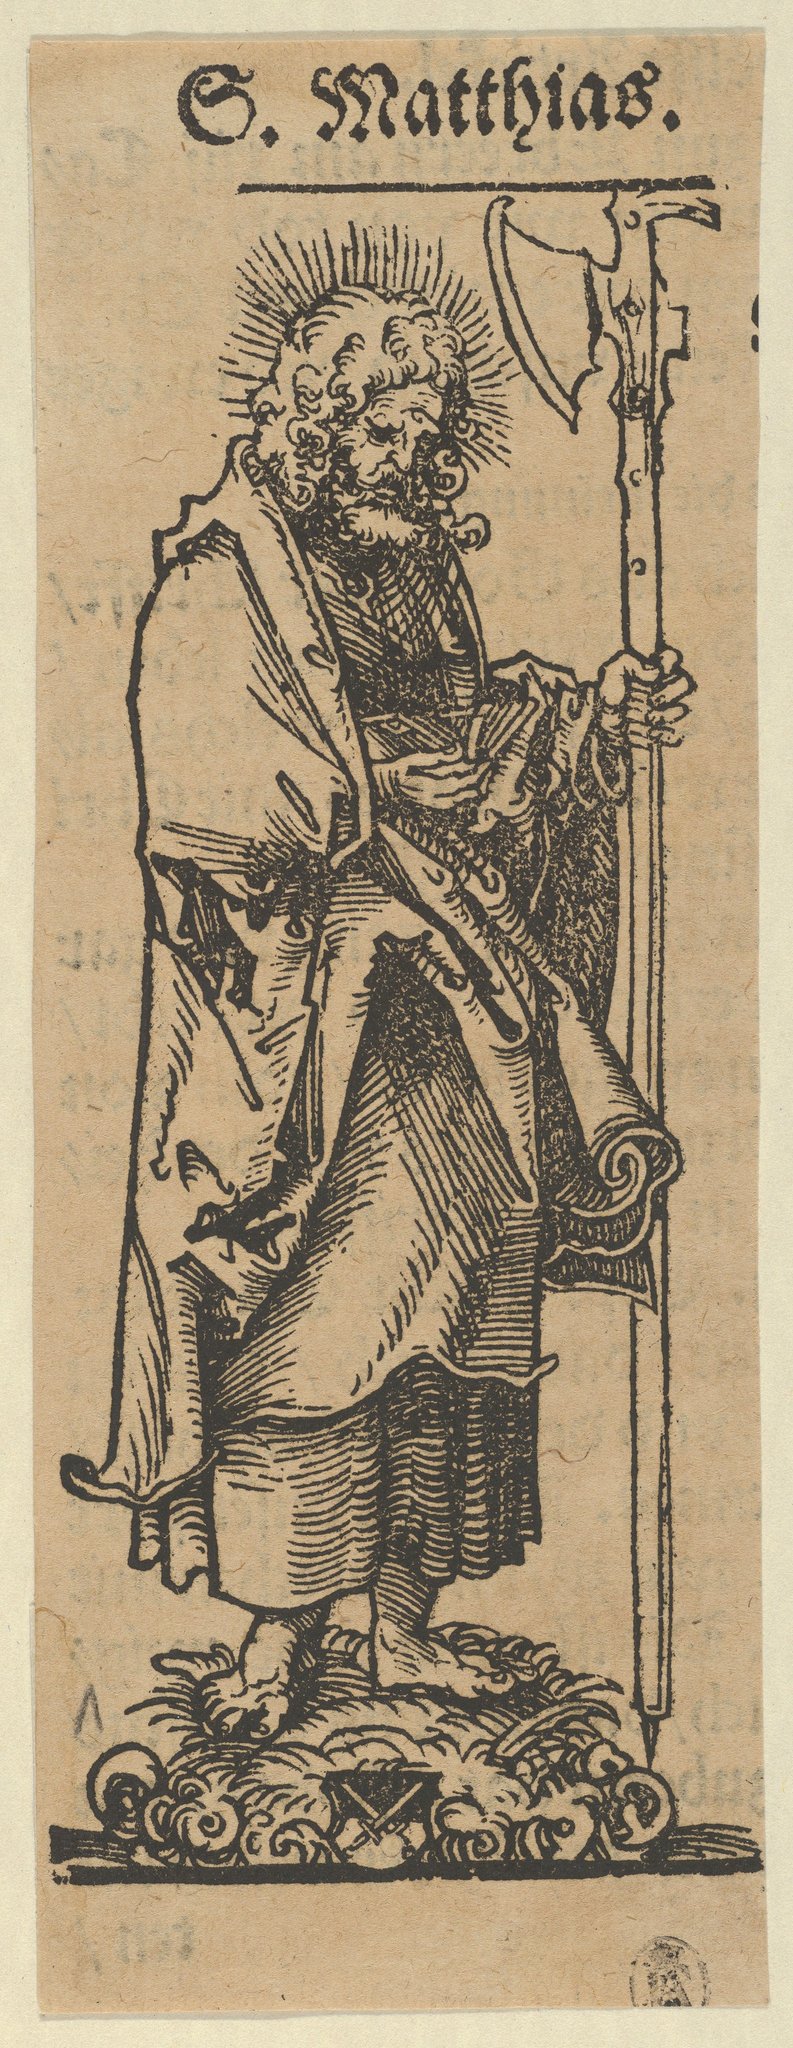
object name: print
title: Silver Statuette of St. Matthew, from the "Wittenberg Reliquaries"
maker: lucas cranach the elder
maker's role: artist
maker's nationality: german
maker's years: 1472-1553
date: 1472-1553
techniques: woodcut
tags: sculpture